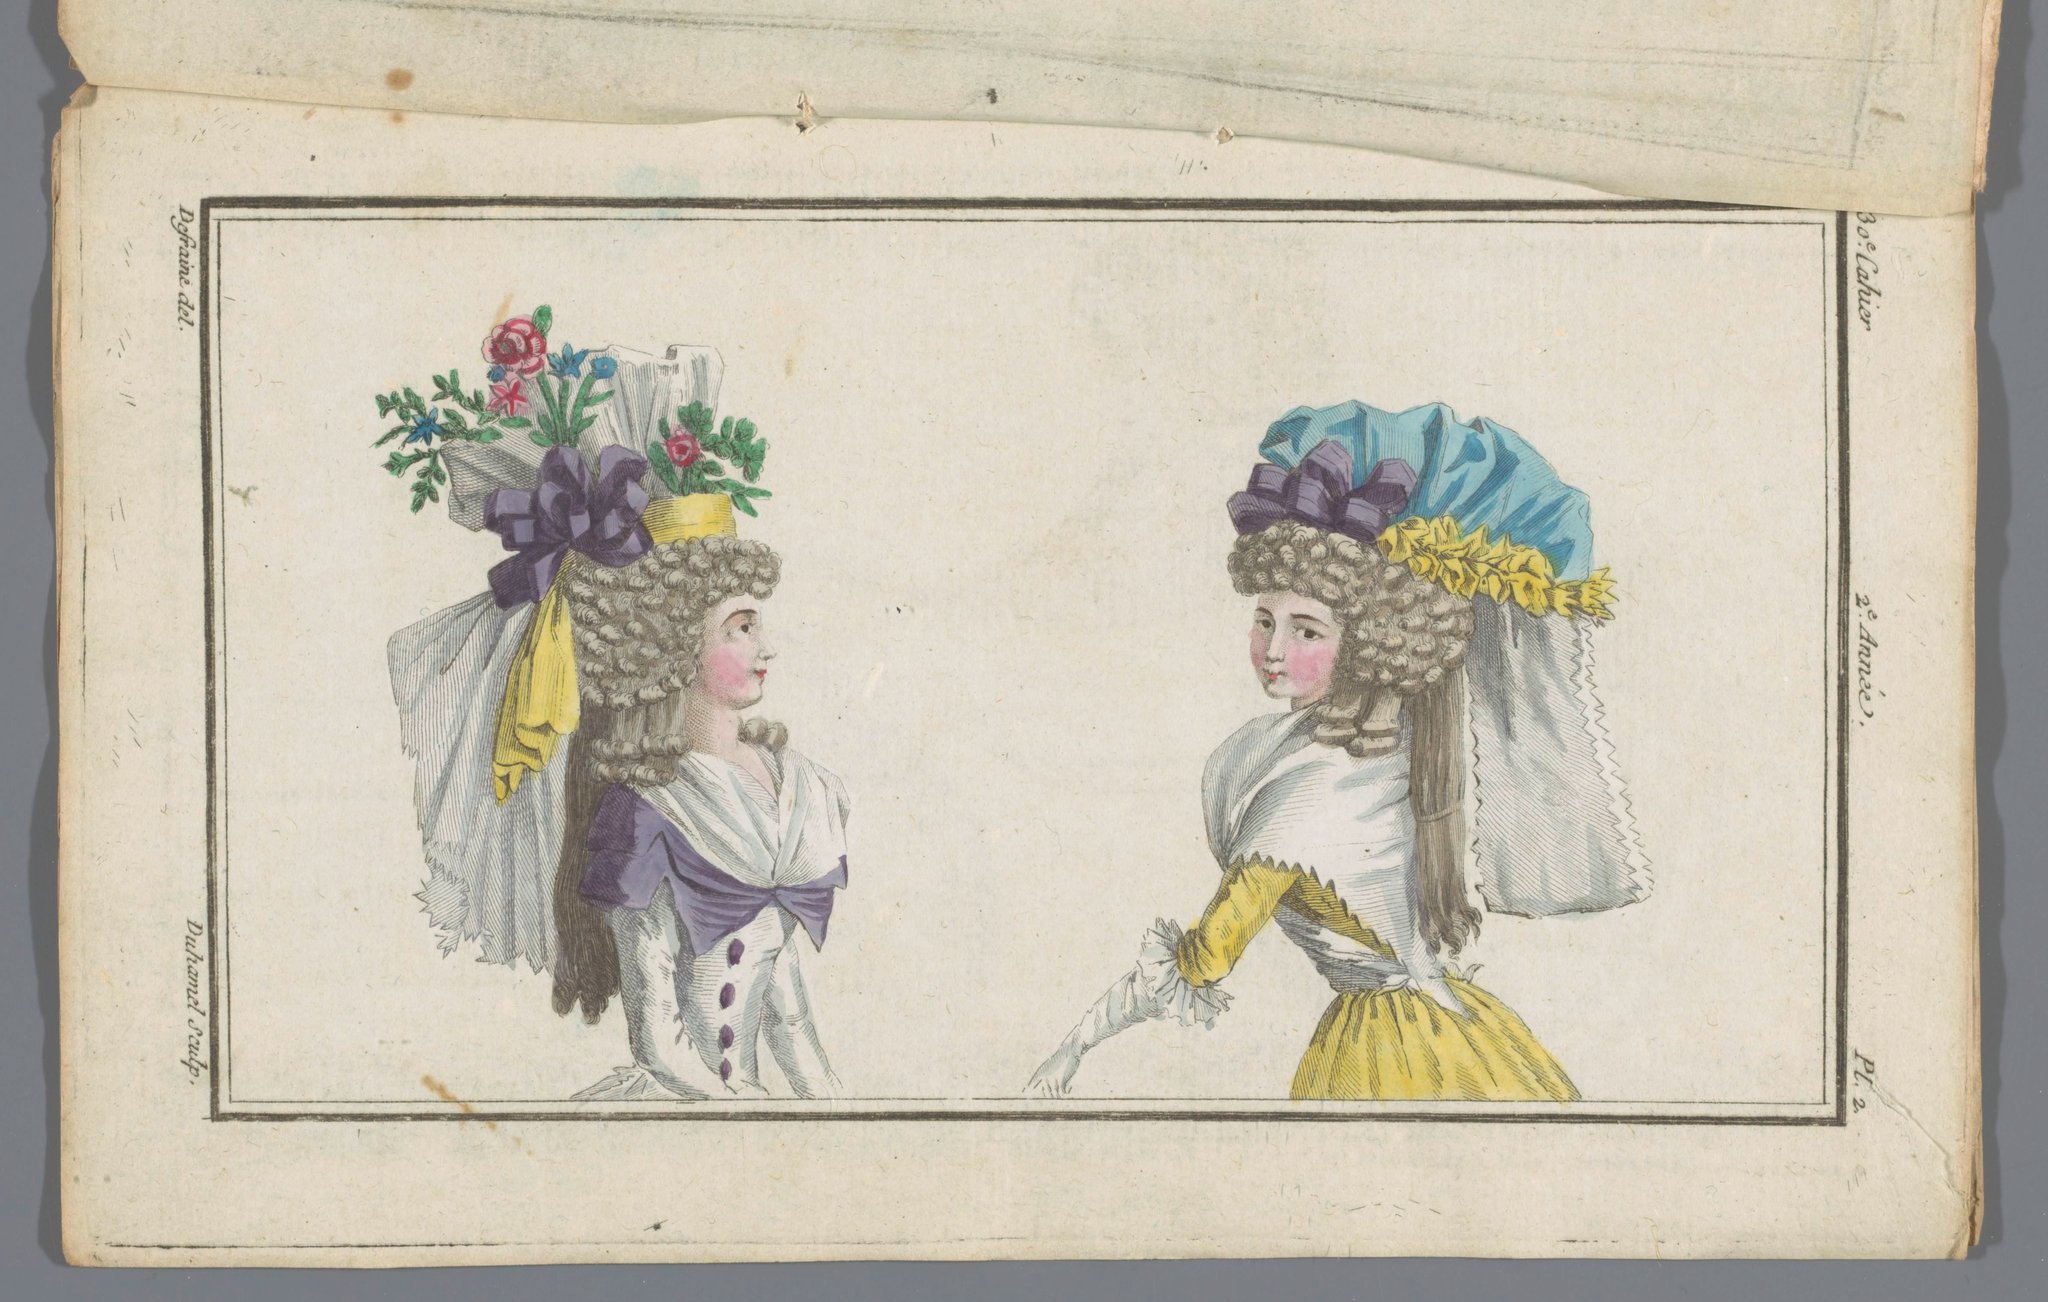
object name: fashion print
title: Magasin des Modes Nouvelles Françaises et Anglaises, 10 septembre 1787, 30e cahier, 2e année, Pl. 2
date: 1787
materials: paper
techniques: engraving, hand coloring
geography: paris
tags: flowers, head-gear: toque (+ women's clothes), head-gear: cap (+ women's clothes), fashion plates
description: Twee vrouwenbustes. Links: muts met een gele band versierd met een paarse strik en bloemen. Rechts: toque van blauwe crêpe versierd met gele guirlande. De prent maakt deel uit van het 30e Cahier, 2e année, uit de serie Magasin des Modes Nouvelles Françaises et Anglaises. De serie bestaat uit 172 modeprenten, uitgegeven door Buisson, Parijs, 20 novembre 1786 - 21 décembre 1789.